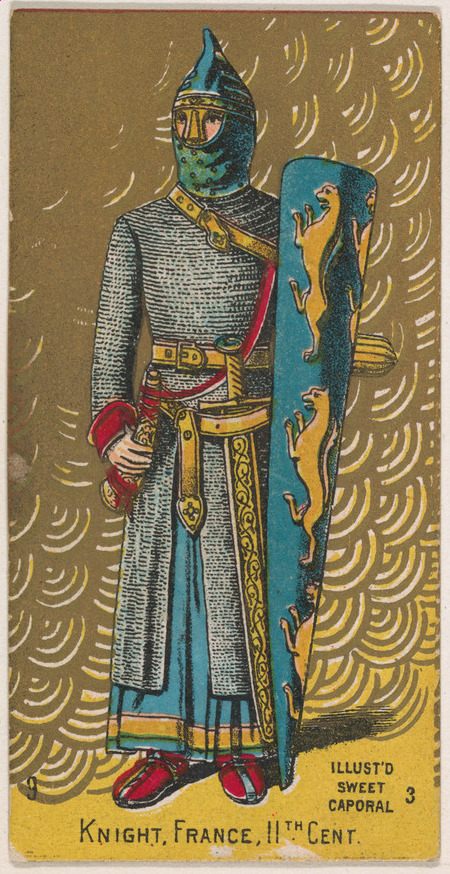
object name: print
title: Knight, France, 11th Century, from the Military Series (N224) issued by Kinney Tobacco Company to promote Sweet Caporal Cigarettes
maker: kinney brothers tobacco company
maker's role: publisher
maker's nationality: american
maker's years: 1869-2011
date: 1888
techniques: color lithograph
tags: men,knights